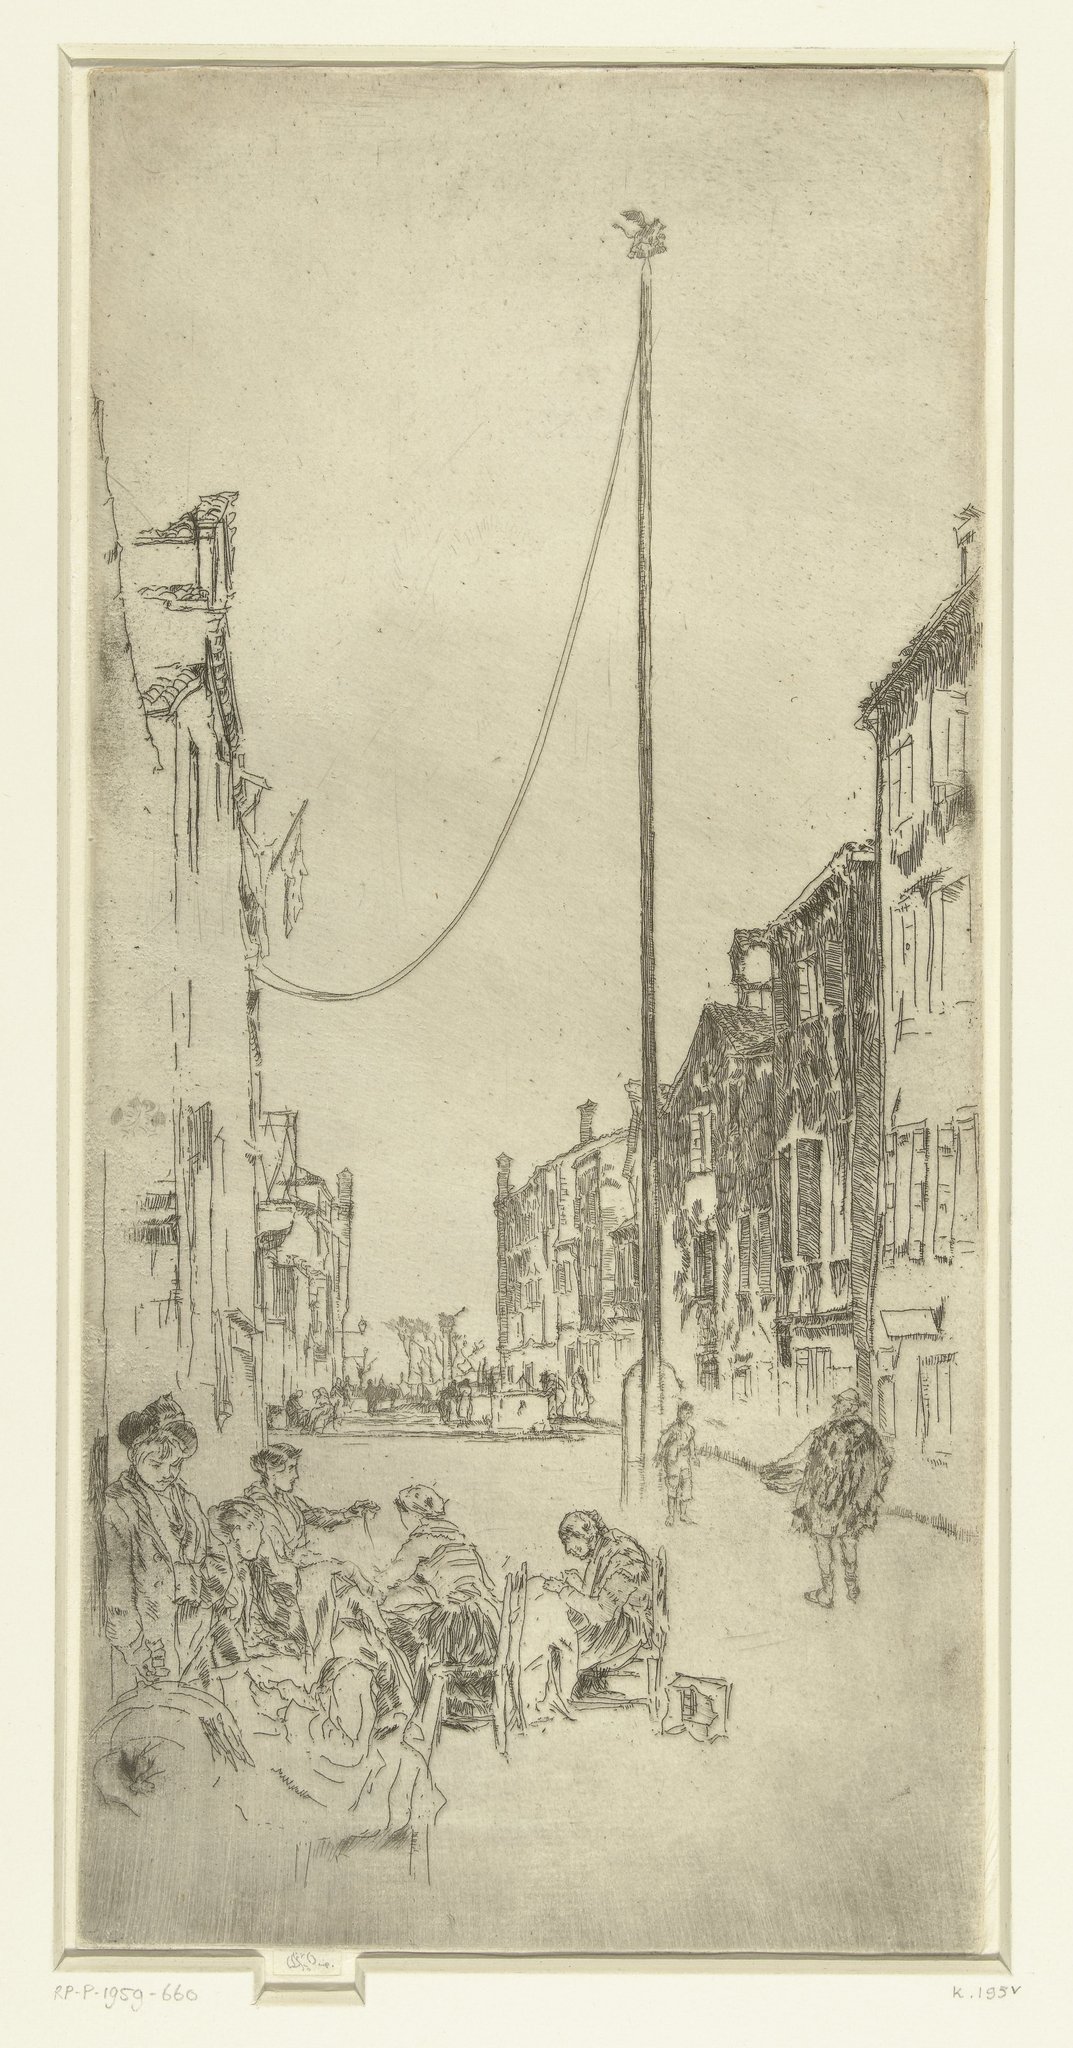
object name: print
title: Venice: Twelve etchings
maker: james abbott mcneill whistler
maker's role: painter, print maker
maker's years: 1834-1903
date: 1879-1880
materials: paper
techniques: drypoint, etching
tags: street, venice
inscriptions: signature: ‘JW imp’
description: Een brede straat in Venetië met een mast. Vrouwen zittend in de straat, zijn bezig met handwerk.